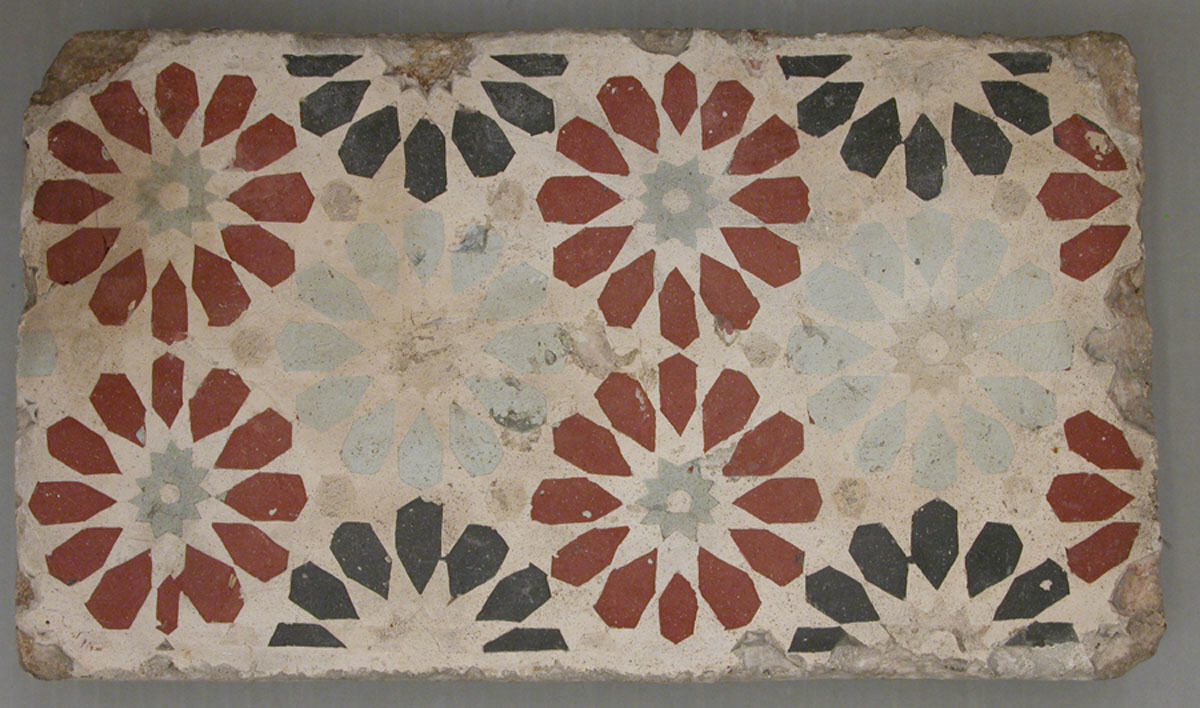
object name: tile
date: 1101-1400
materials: earthenware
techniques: glazing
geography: egypt